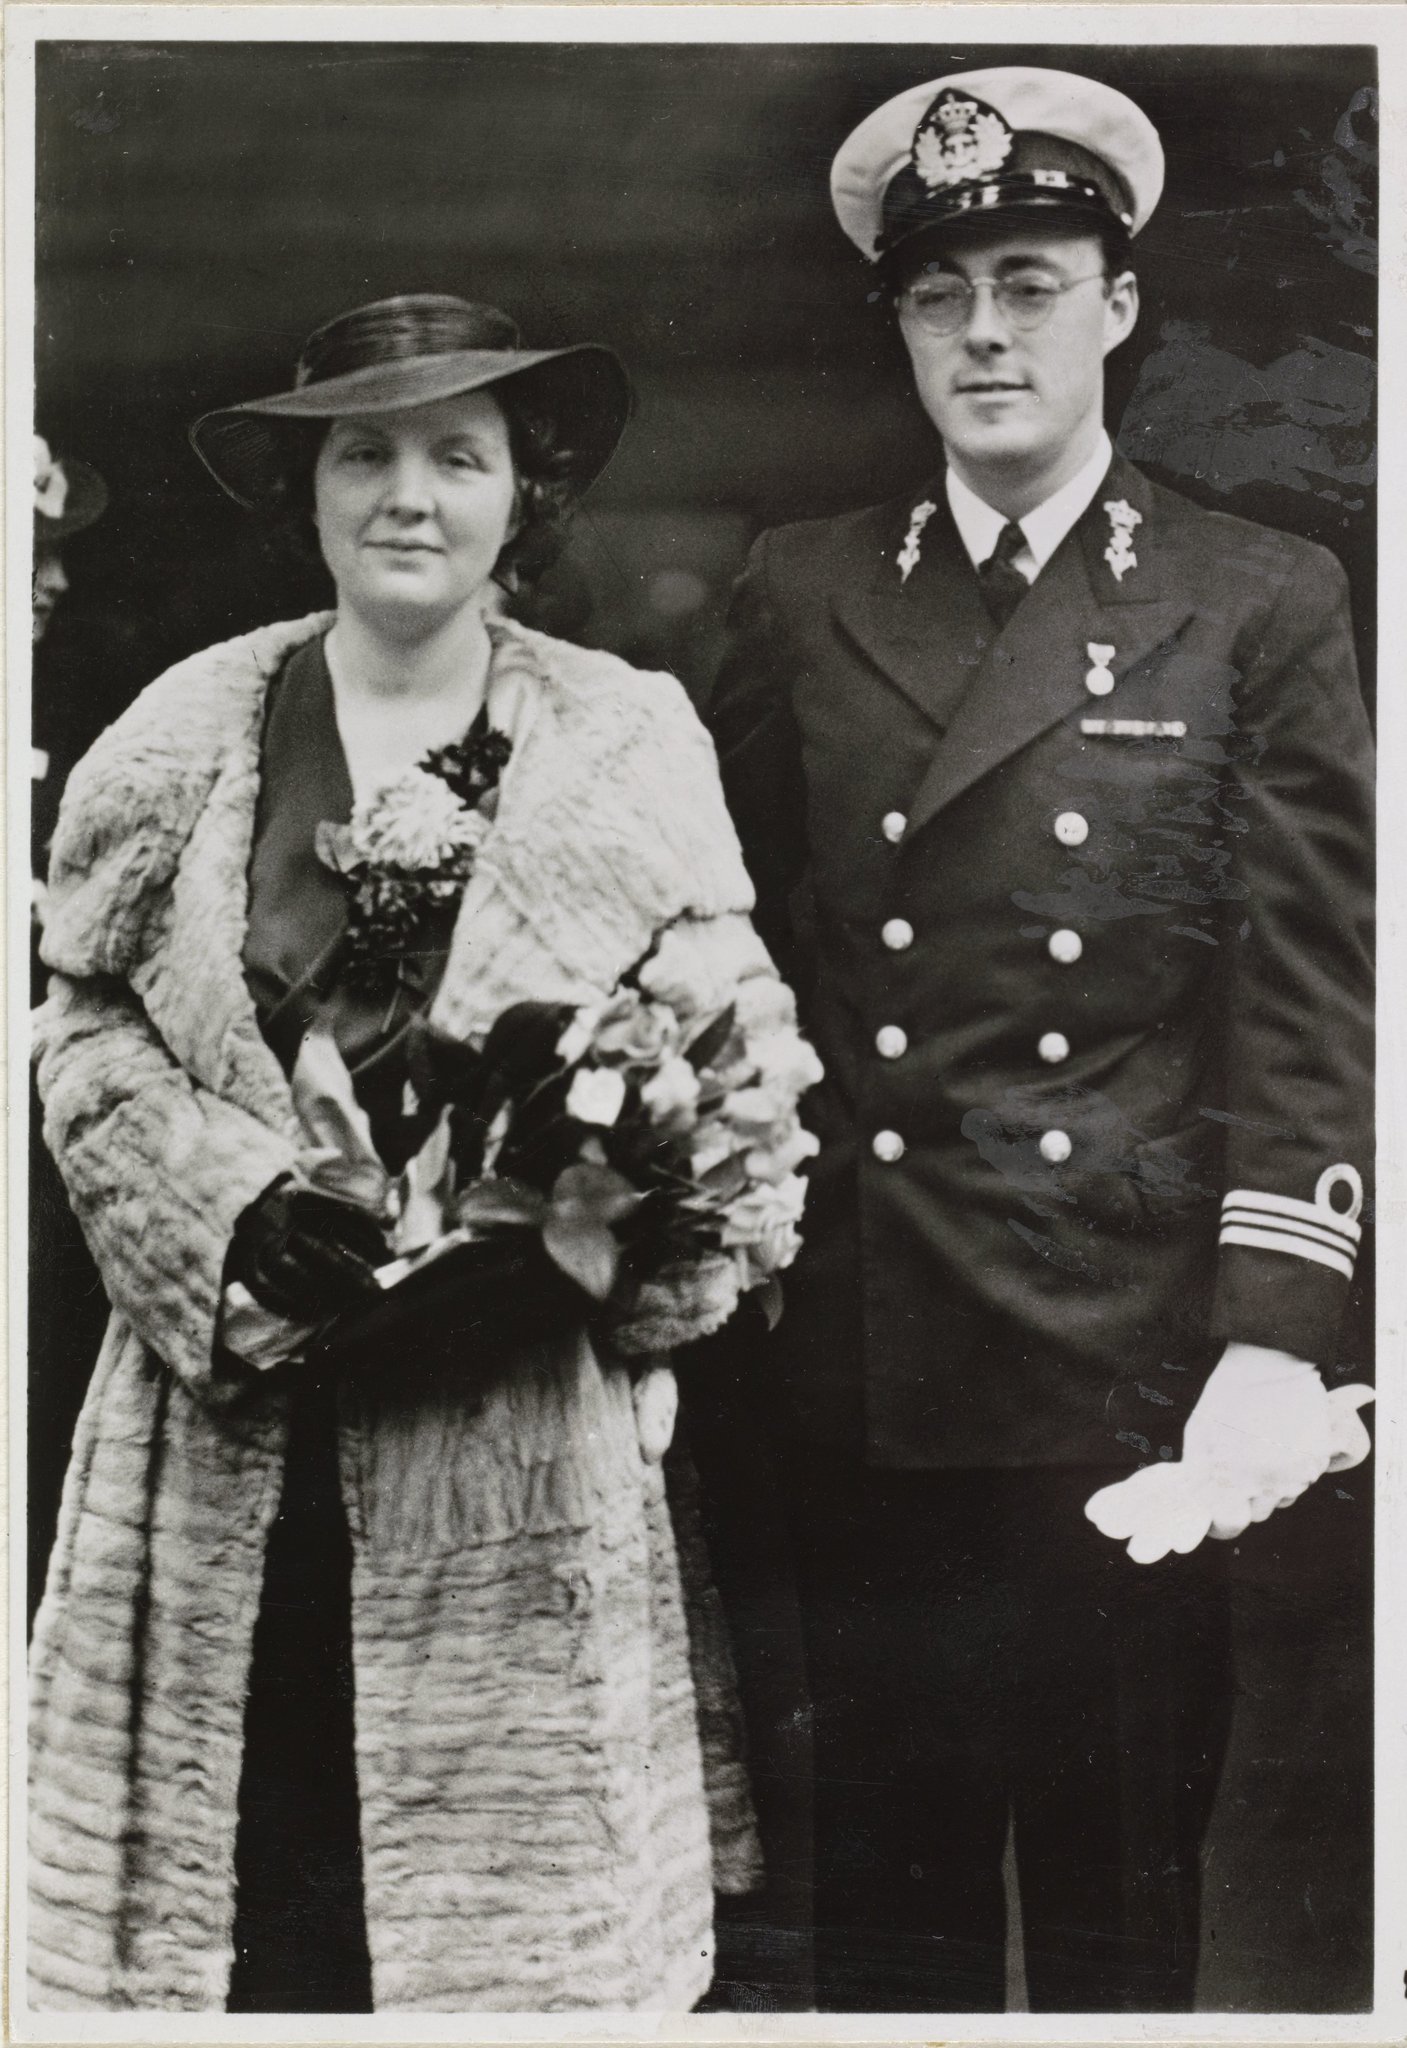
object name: photograph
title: Juliana, koningin der Nederlanden, en Bernhard van Lippe-Biesterfeld terugkerend van de kroningsfeesten te Londen op 22 mei 1937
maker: Anonymous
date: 1937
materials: photographic support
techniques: photography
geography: netherlands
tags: utrecht, bernhard (prins der nederlanden), juliana of the netherlands, london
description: De hier vermelde titel verwijst naar de hoogst verkregen titel van de geportretteerde, niet per se naar de titel die de geportretteerde op deze voorstelling draagt.